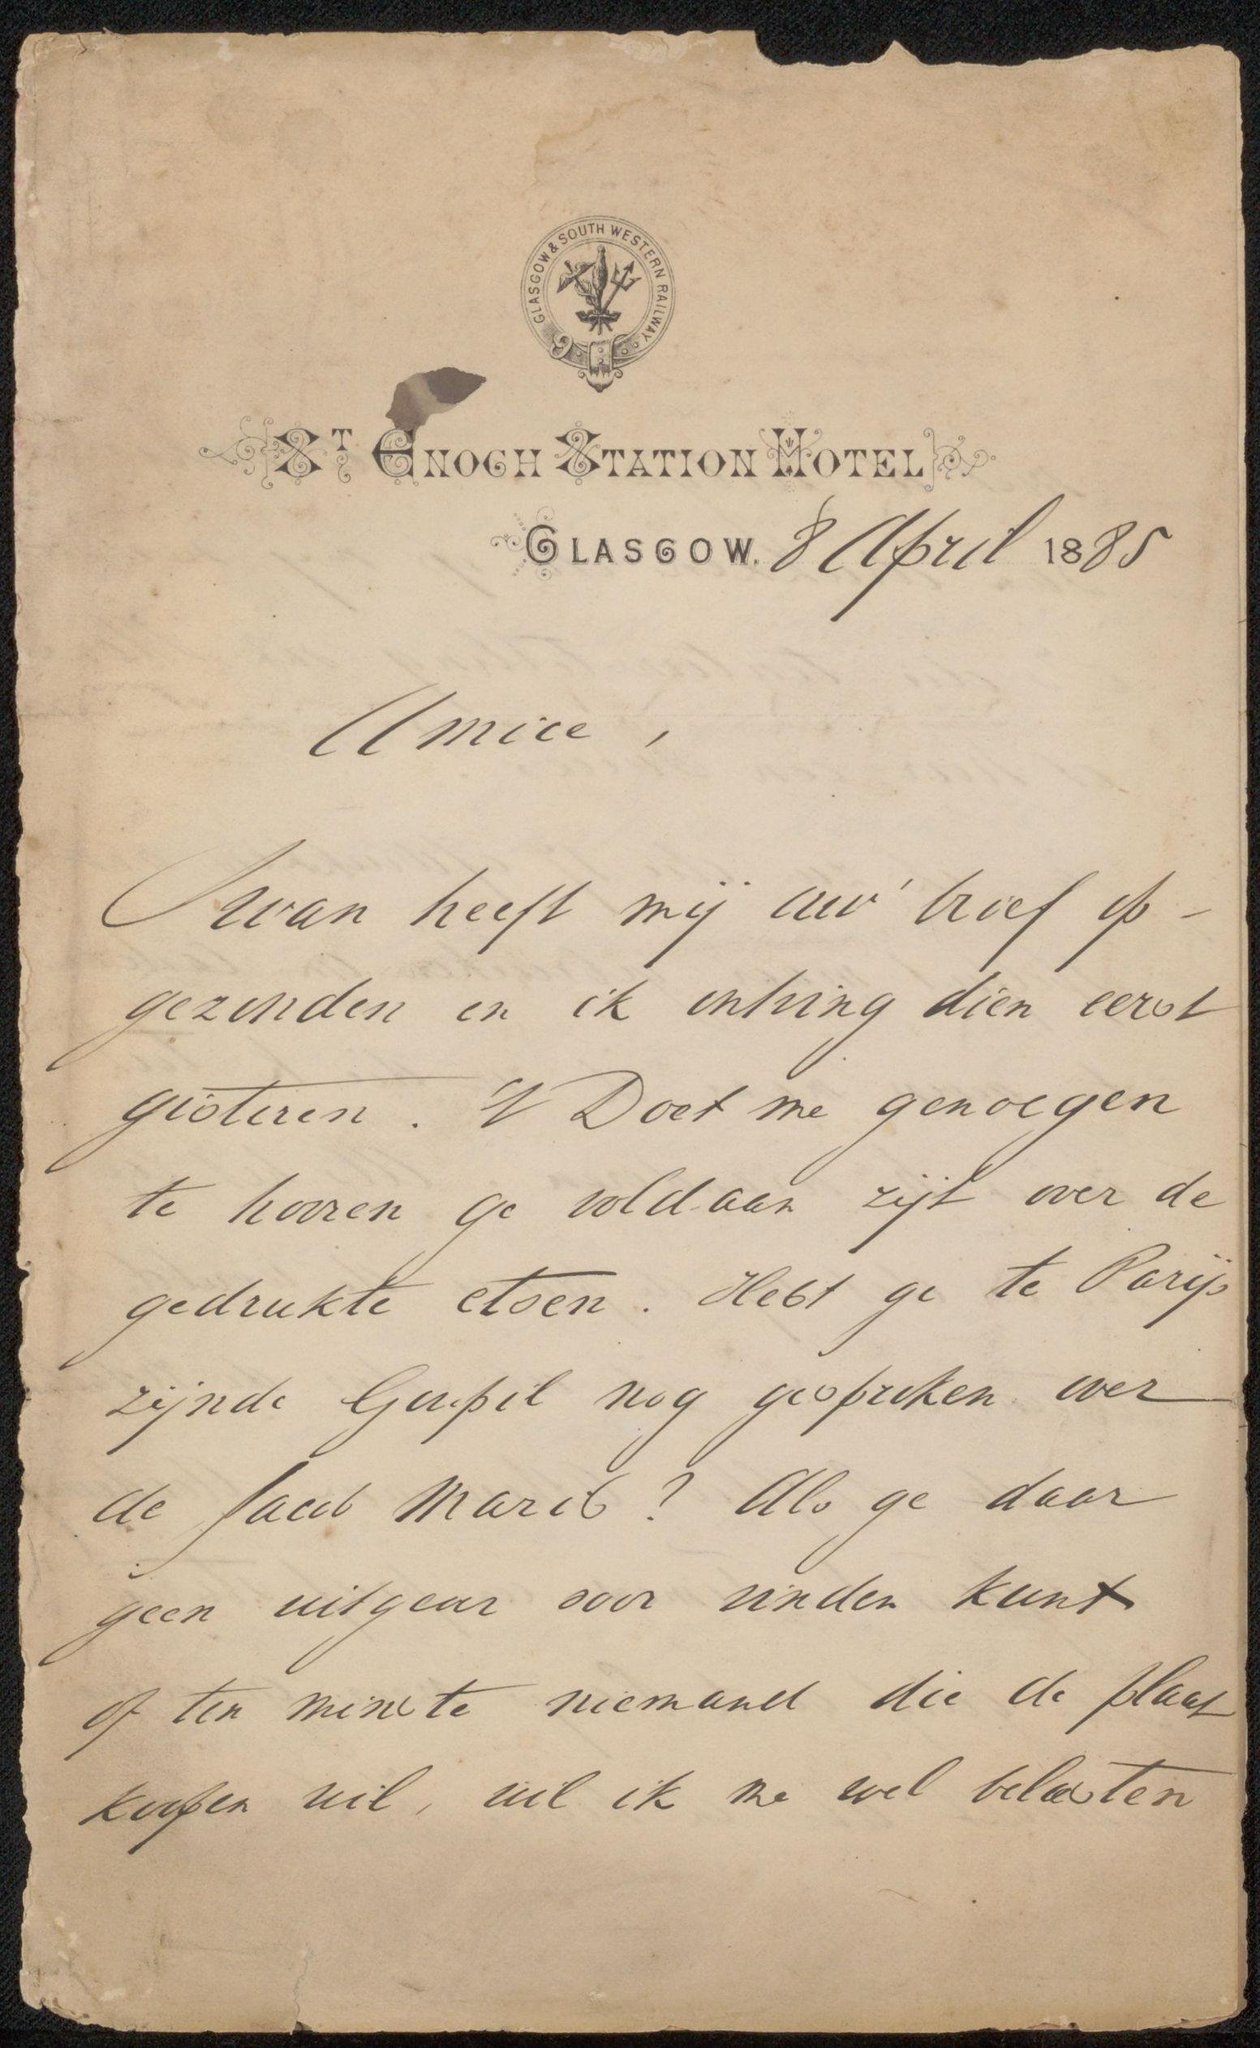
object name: letter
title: Brief aan Philip Zilcken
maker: elbert jan van wisselingh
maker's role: kunsthandelaar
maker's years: 1848-1912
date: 1885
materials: ink, paper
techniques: pen, printing, writing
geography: glasgow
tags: paris, print maker, draughtsman, eugène delacroix, the hague, jacob maris, painter, jean françois millet, printer, publisher, philip zilcken, the graphic arts, exhibition ~ art, london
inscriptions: collector's mark: ‘RPK’